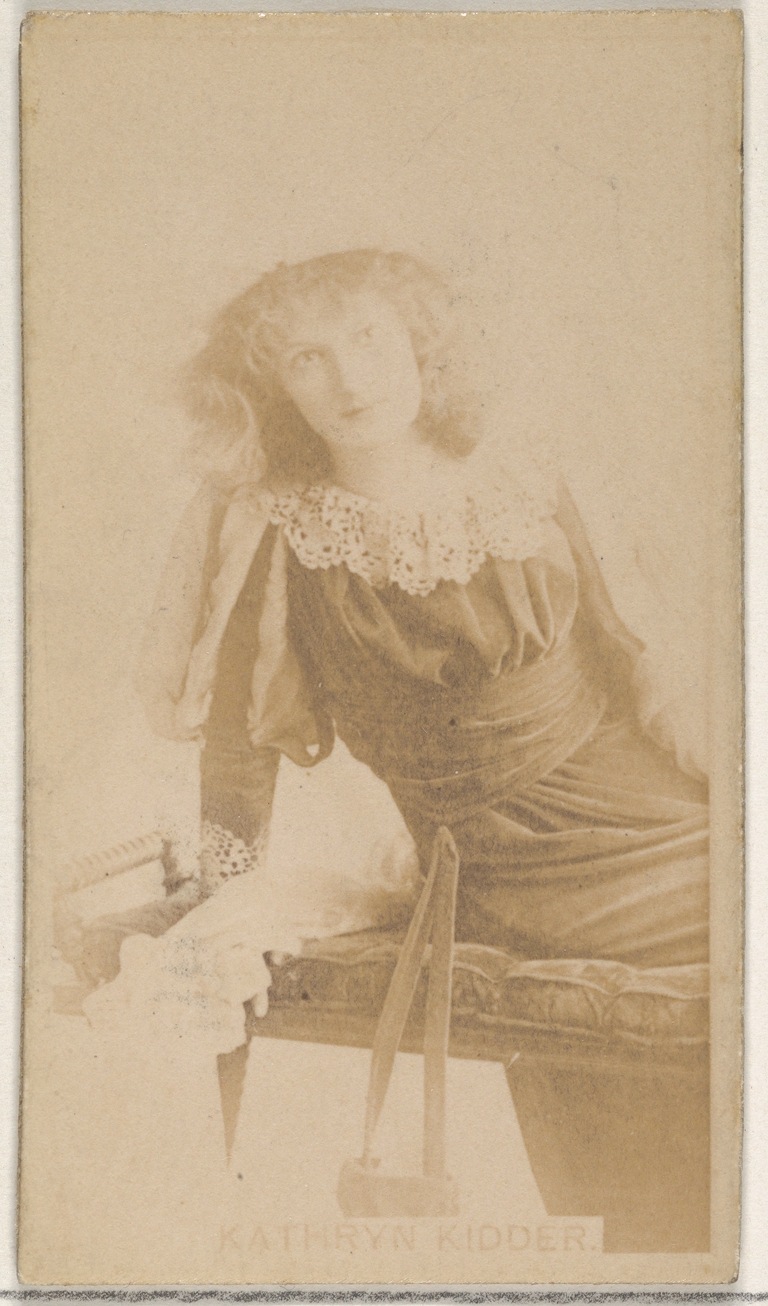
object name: photograph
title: Kathryn Kidder, from the Actors and Actresses series (N45, Type 8) for Virginia Brights Cigarettes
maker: allen & ginter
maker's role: publisher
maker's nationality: american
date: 1888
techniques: albumen silver print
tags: portraits,women,actresses